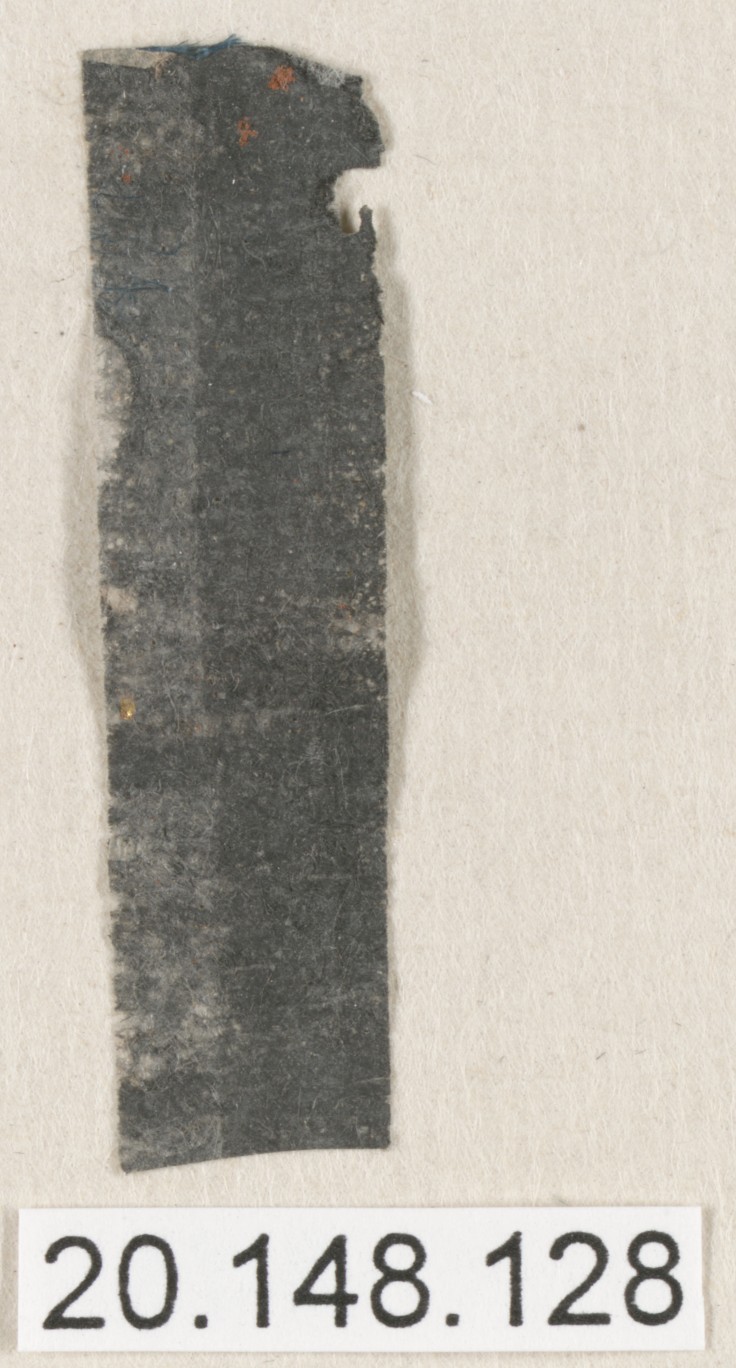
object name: textile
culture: chinese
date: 1501-1600